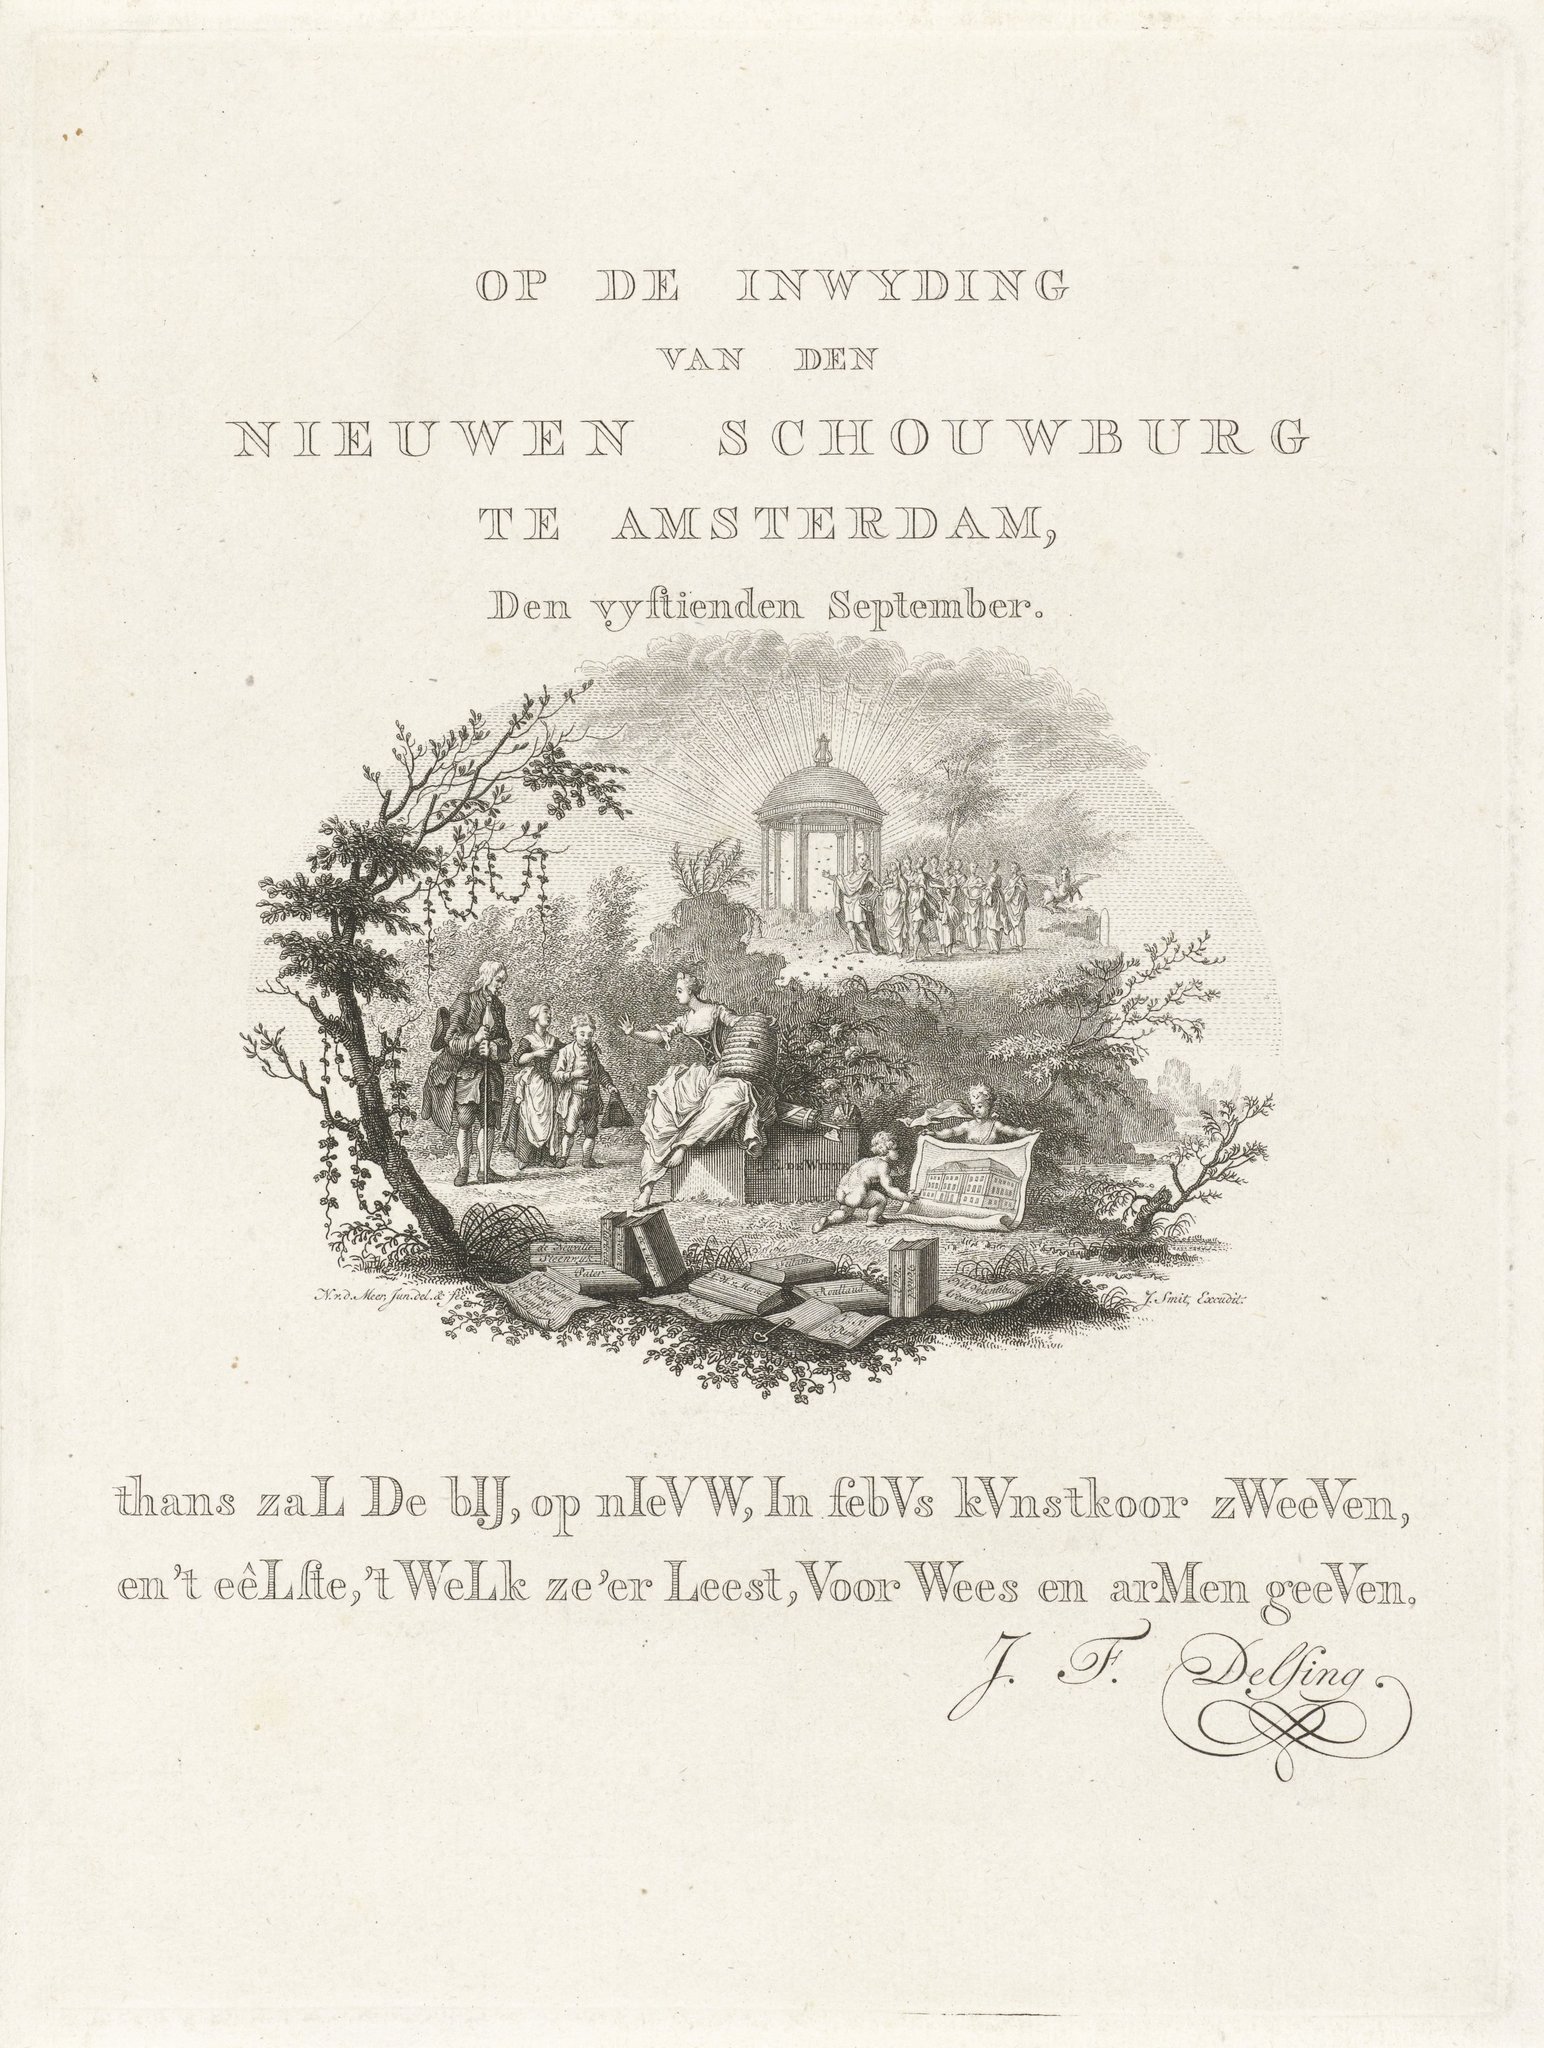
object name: book illustration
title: Tijdvers op de inwijding van de schouwburg aan het Leidseplein te Amsterdam, 1774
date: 1774-1775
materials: paper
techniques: engraving, etching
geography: amsterdam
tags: pegasus, the winged horse, apollo and the muses, apollo musagetes, theatre (building), bee-hive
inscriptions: collector's mark: Lugt 2228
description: Blad met een ovale allegorische voorstelling en een tweeregelig tijdvers op de inwijding van de nieuwe Amsterdamse Schouwburg op het Leidseplein, 15 september 1774. Deze stadsschouwburg werd gebouwd om de in 1772 afgebrande schouwburg aan de Keizersgracht te vervangen en brandde in 1890 zelf af. In het midden verwelkomt de personificatie van de Amsterdamse Schouwburg, met op haar schoot een nieuwe bijenkorf, een man en twee kinderen. Rechts van haar twee putti die een afbeelding van het nieuwe gebouw ontrollen. Op de voorgrond boeken en geschriften met toneelwerken. In het verschiet Apollo, de muzen en Pegasus op de Parnassus.